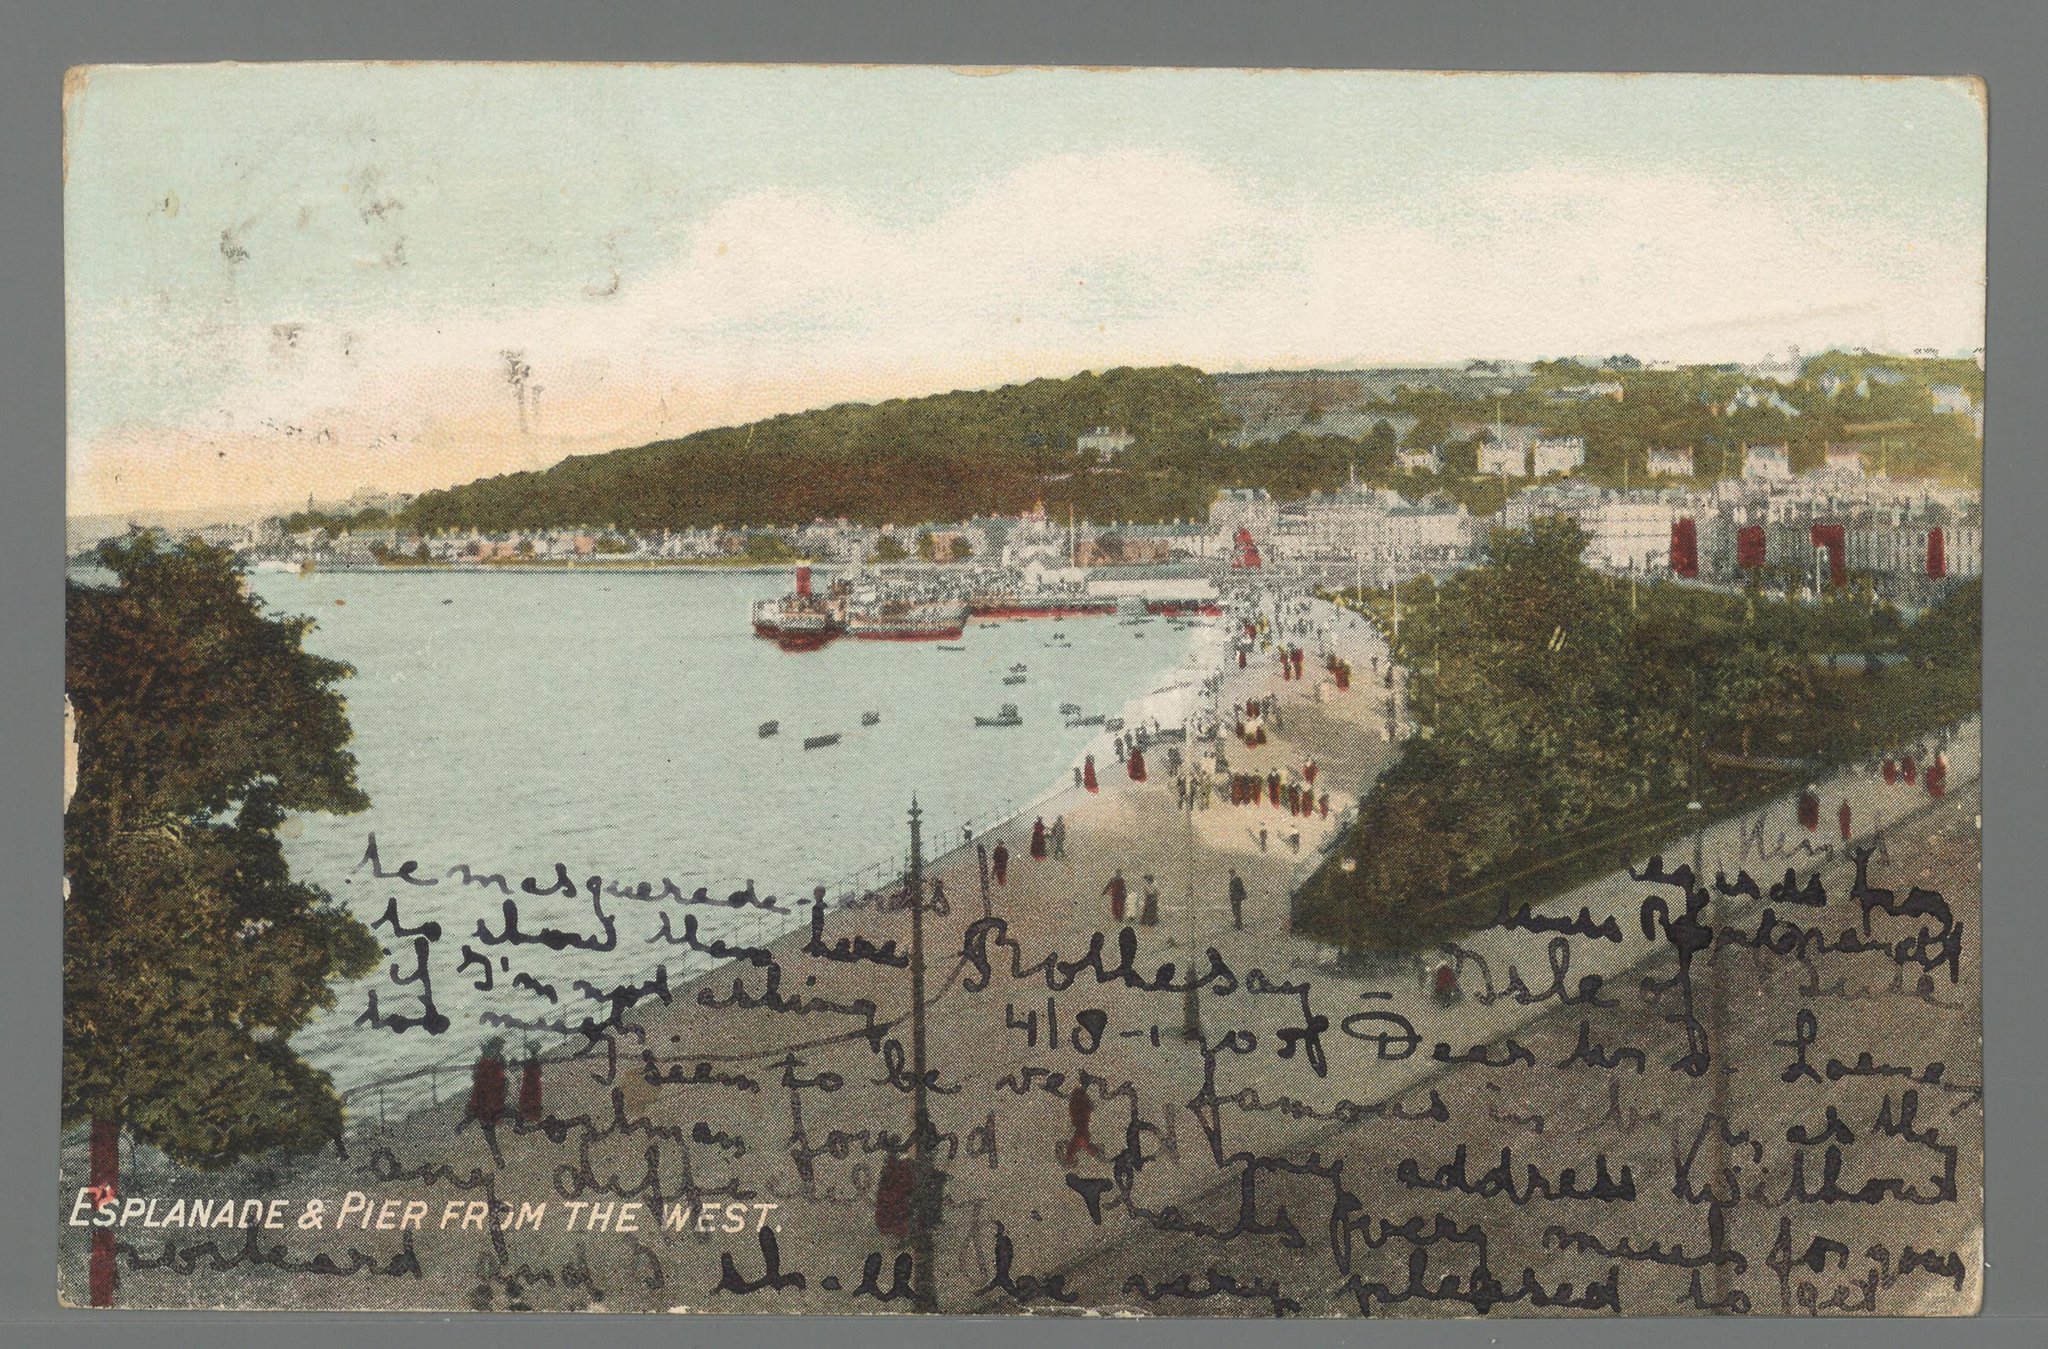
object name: photomechanical print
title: Esplanade & pier from the west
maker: Anonymous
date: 1902-1905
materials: cardboard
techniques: lithograph, writing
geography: glasgow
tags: pier, quay, wharf, sea, glasgow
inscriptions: postage stamp